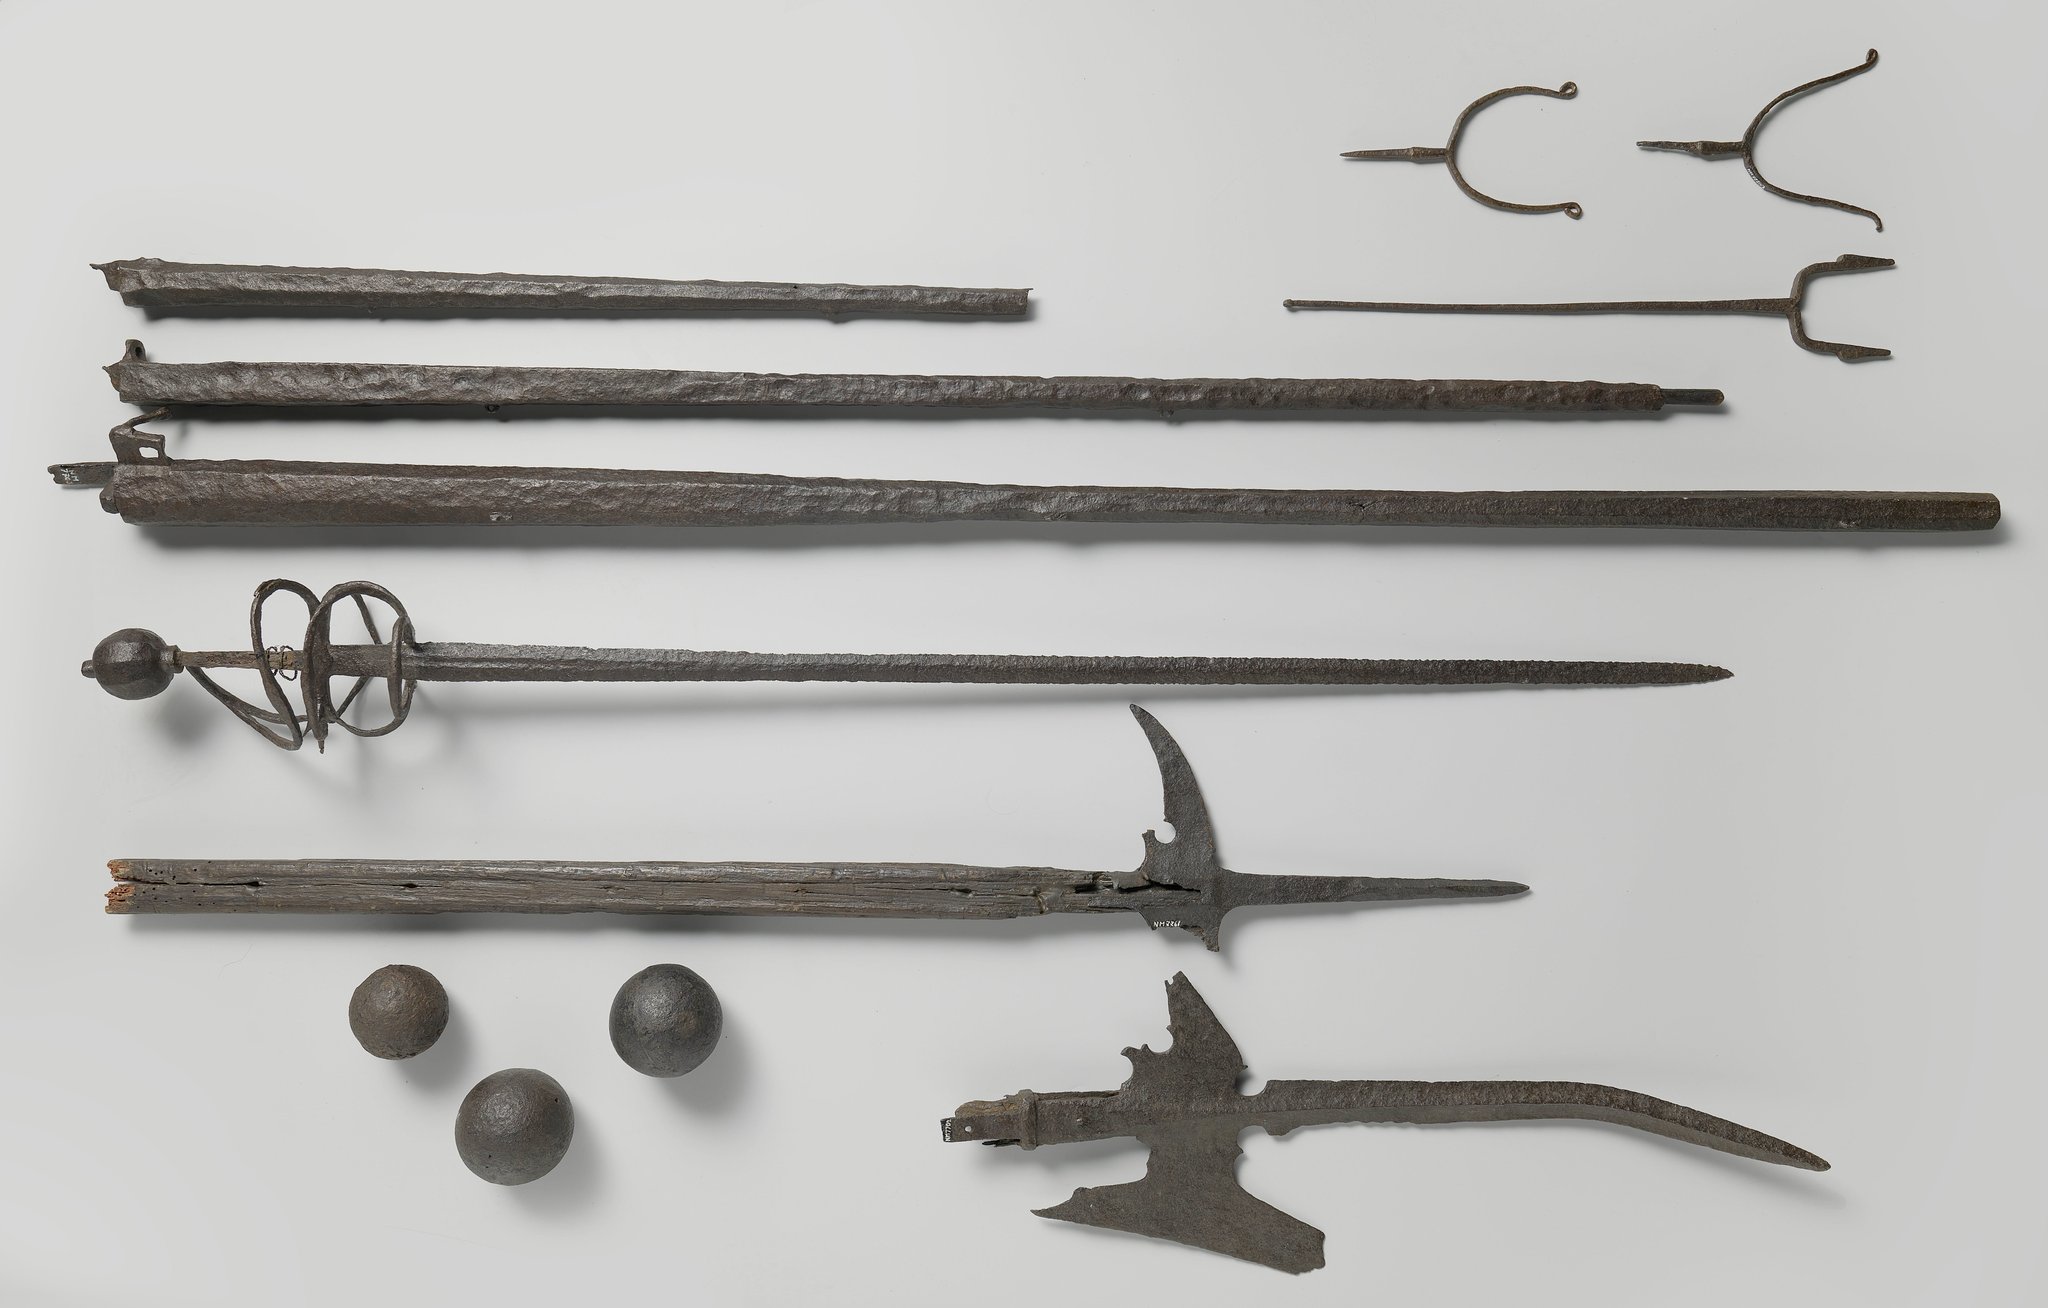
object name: bullet ammunition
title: Kanonskogel voor tweeponders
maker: Anonymous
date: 1590-1596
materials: iron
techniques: casting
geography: netherlands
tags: willem barendsz., amsterdam, jacob van heemskerck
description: Kanonskogel voor kanon van 2 lb. De gietnaad is half zichtbaar.